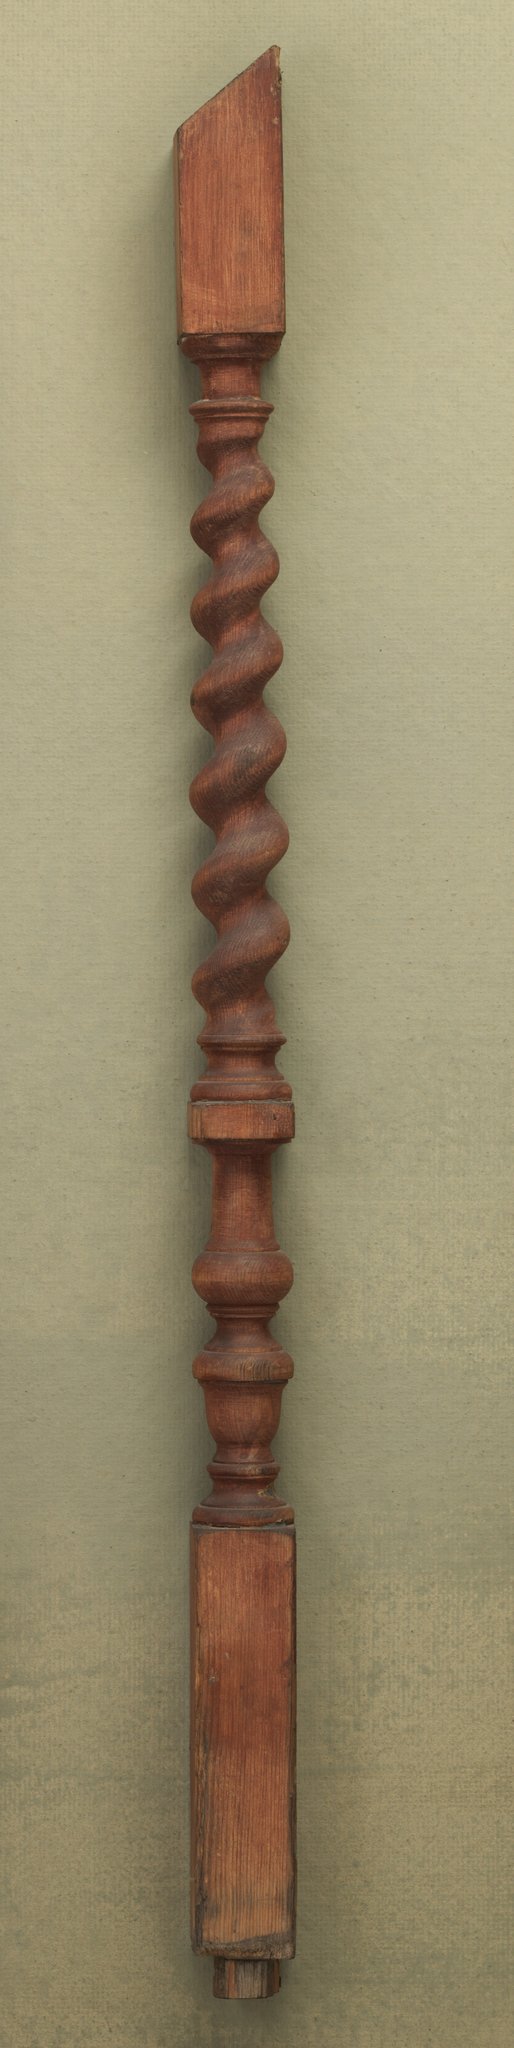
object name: baluster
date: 1701-1750